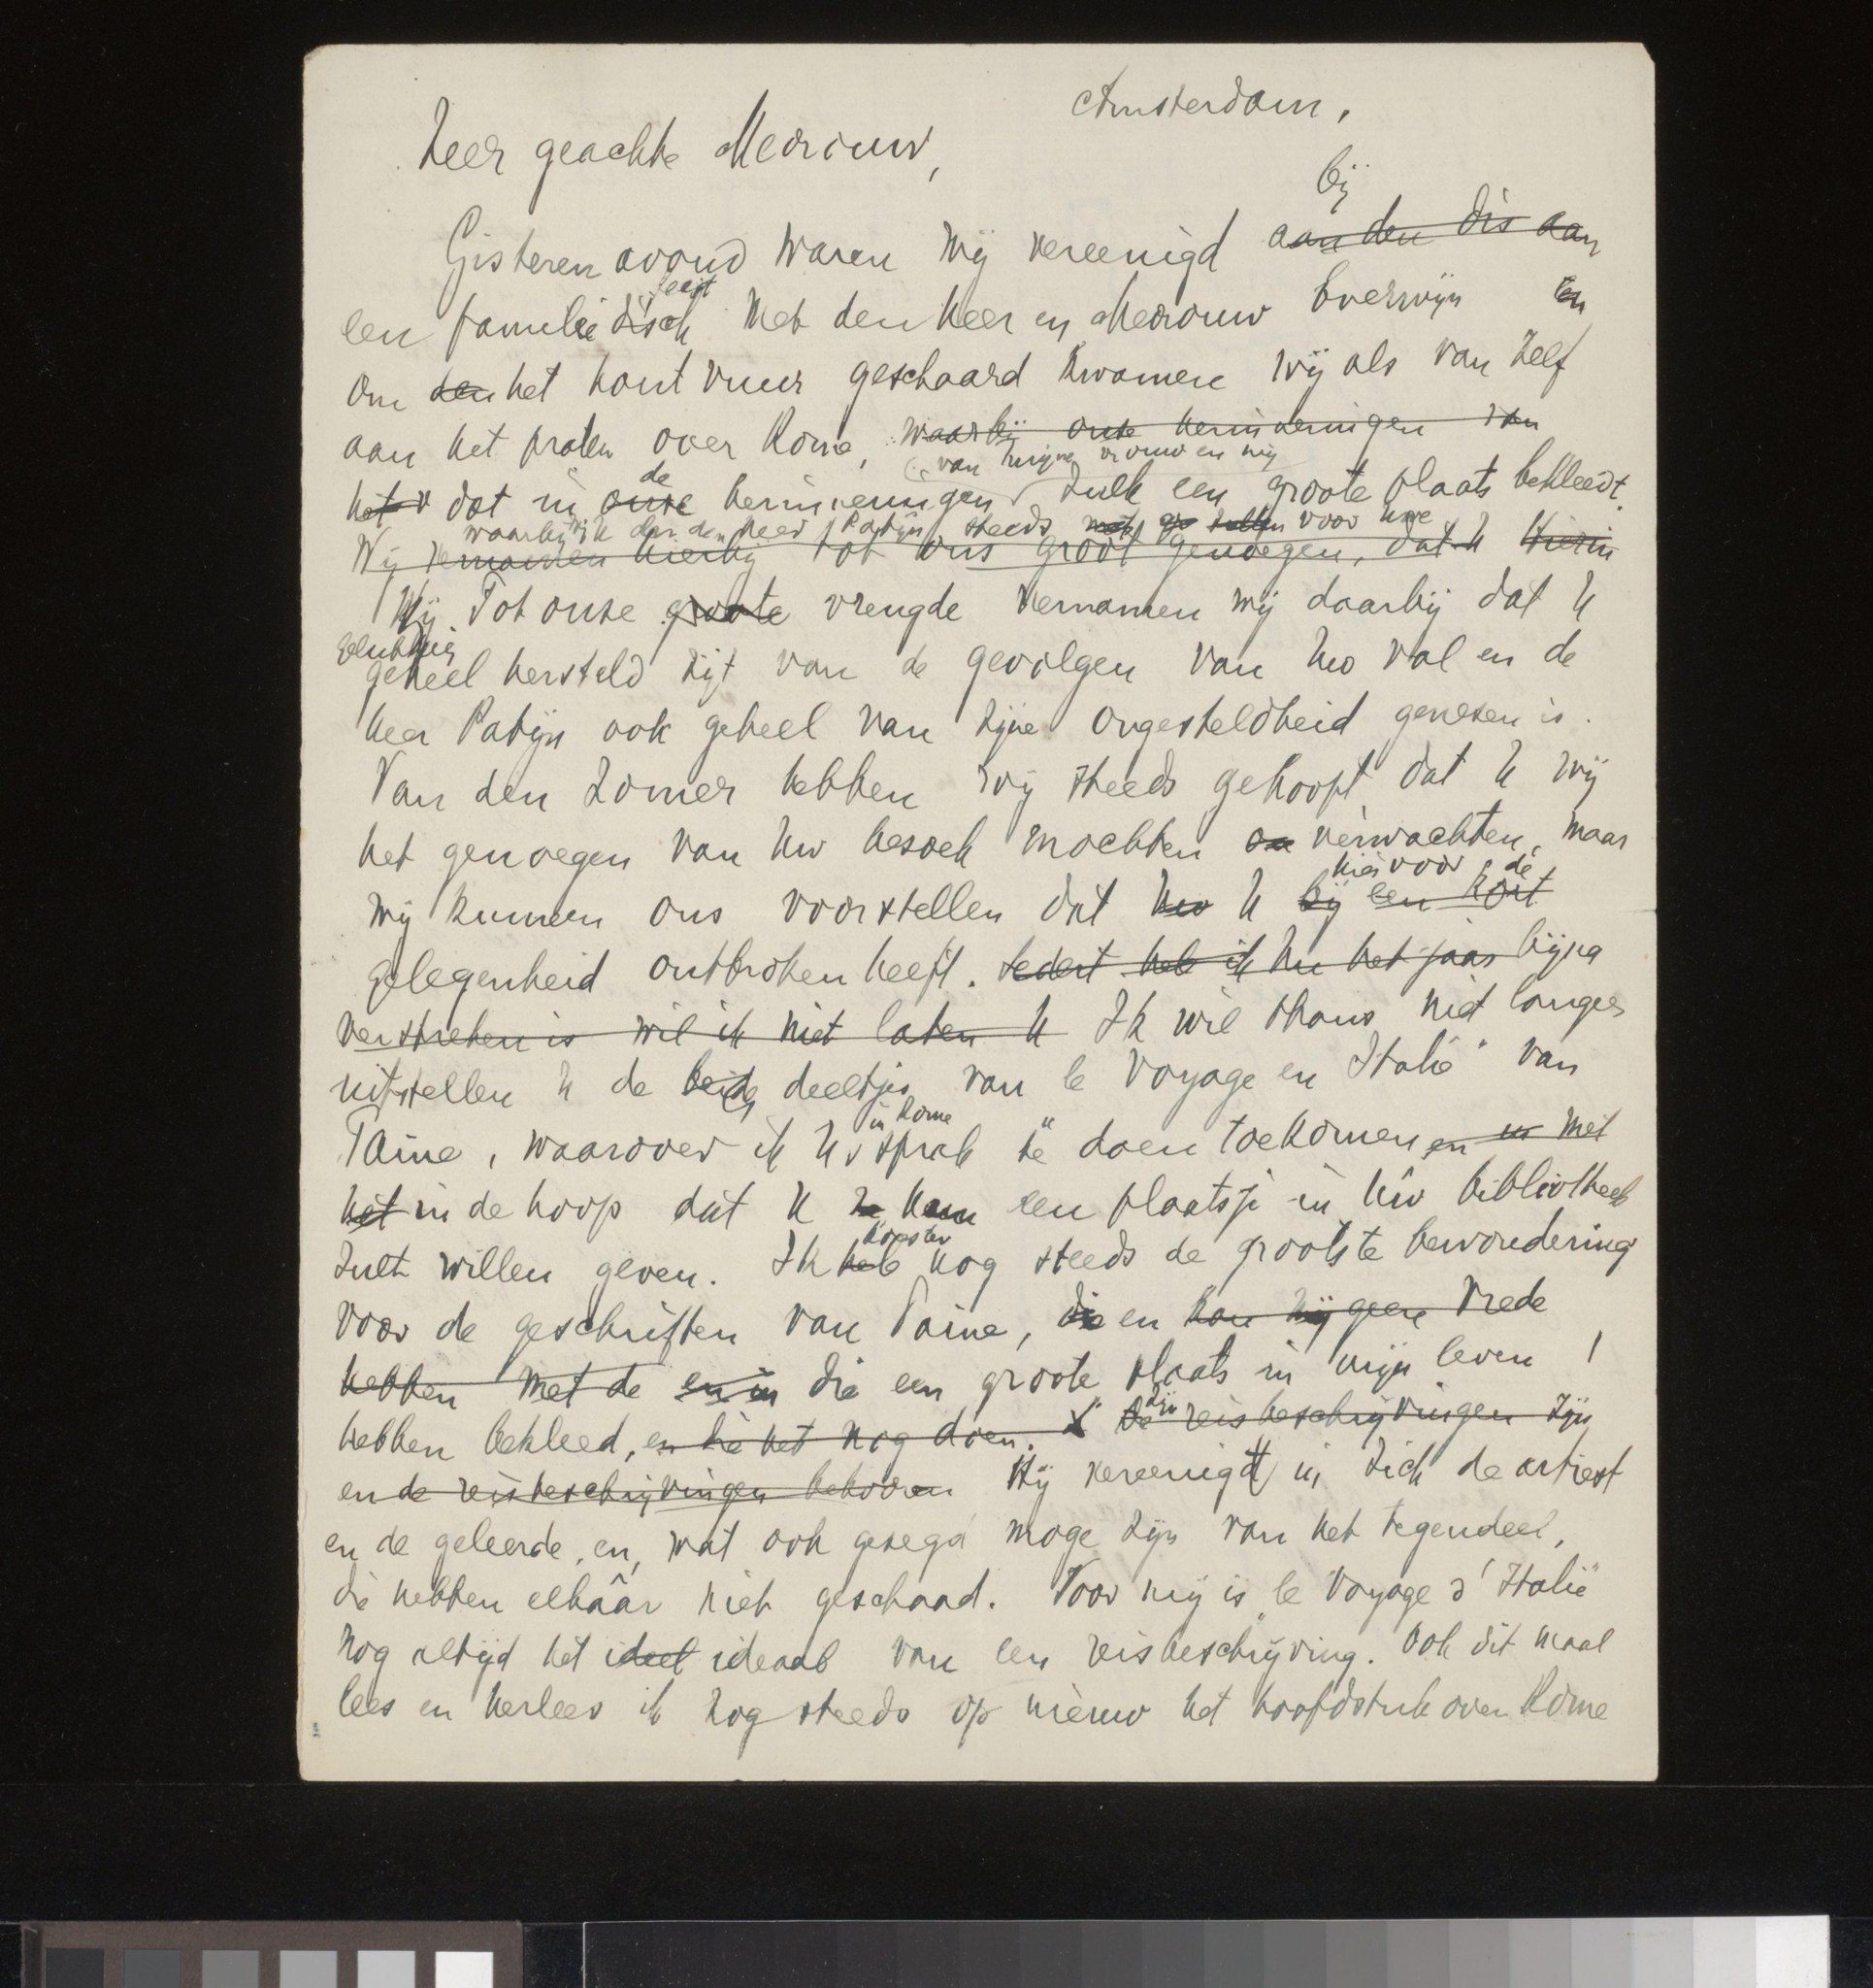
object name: letter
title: Concetbrief aan jonkvrouw Elisabeth Wilhelmina Malwina de Brauw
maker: andries bonger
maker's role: kunstverzamelaar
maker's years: 1861-1936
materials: ink, paper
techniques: pen, writing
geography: amsterdam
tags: jonkvrouw elisabeth wilhelmina malwina de brauw, historicus, criticus, hippolyte taine